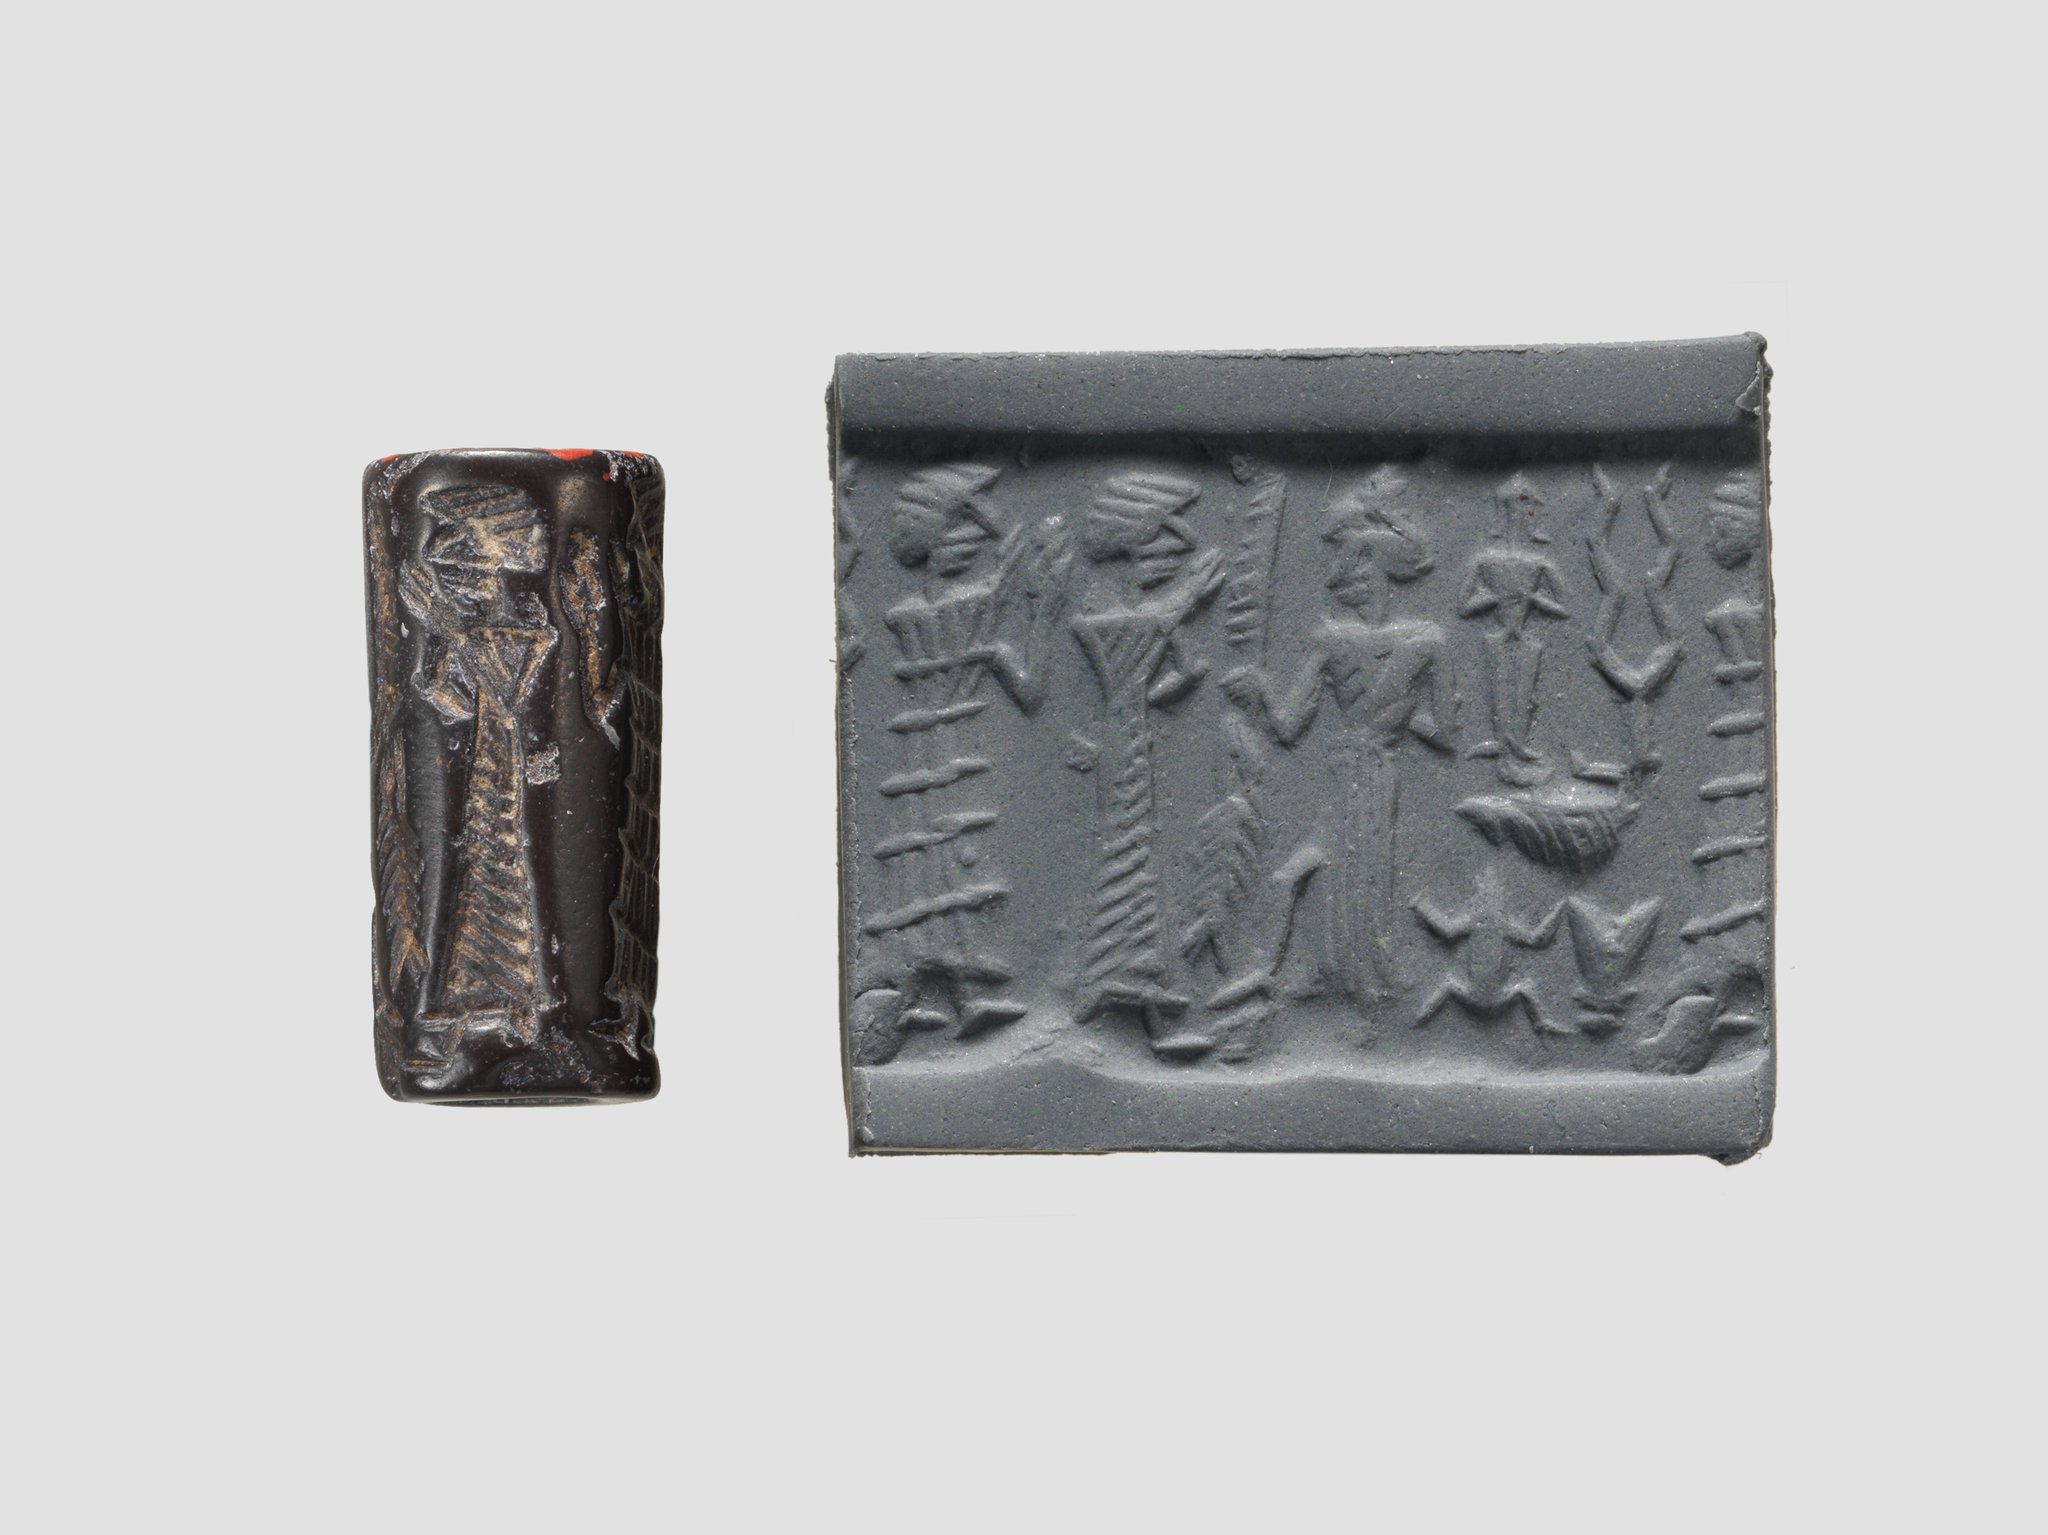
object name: cylinder seal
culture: assyrian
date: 2000-1668 BCE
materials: mineral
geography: anatolia